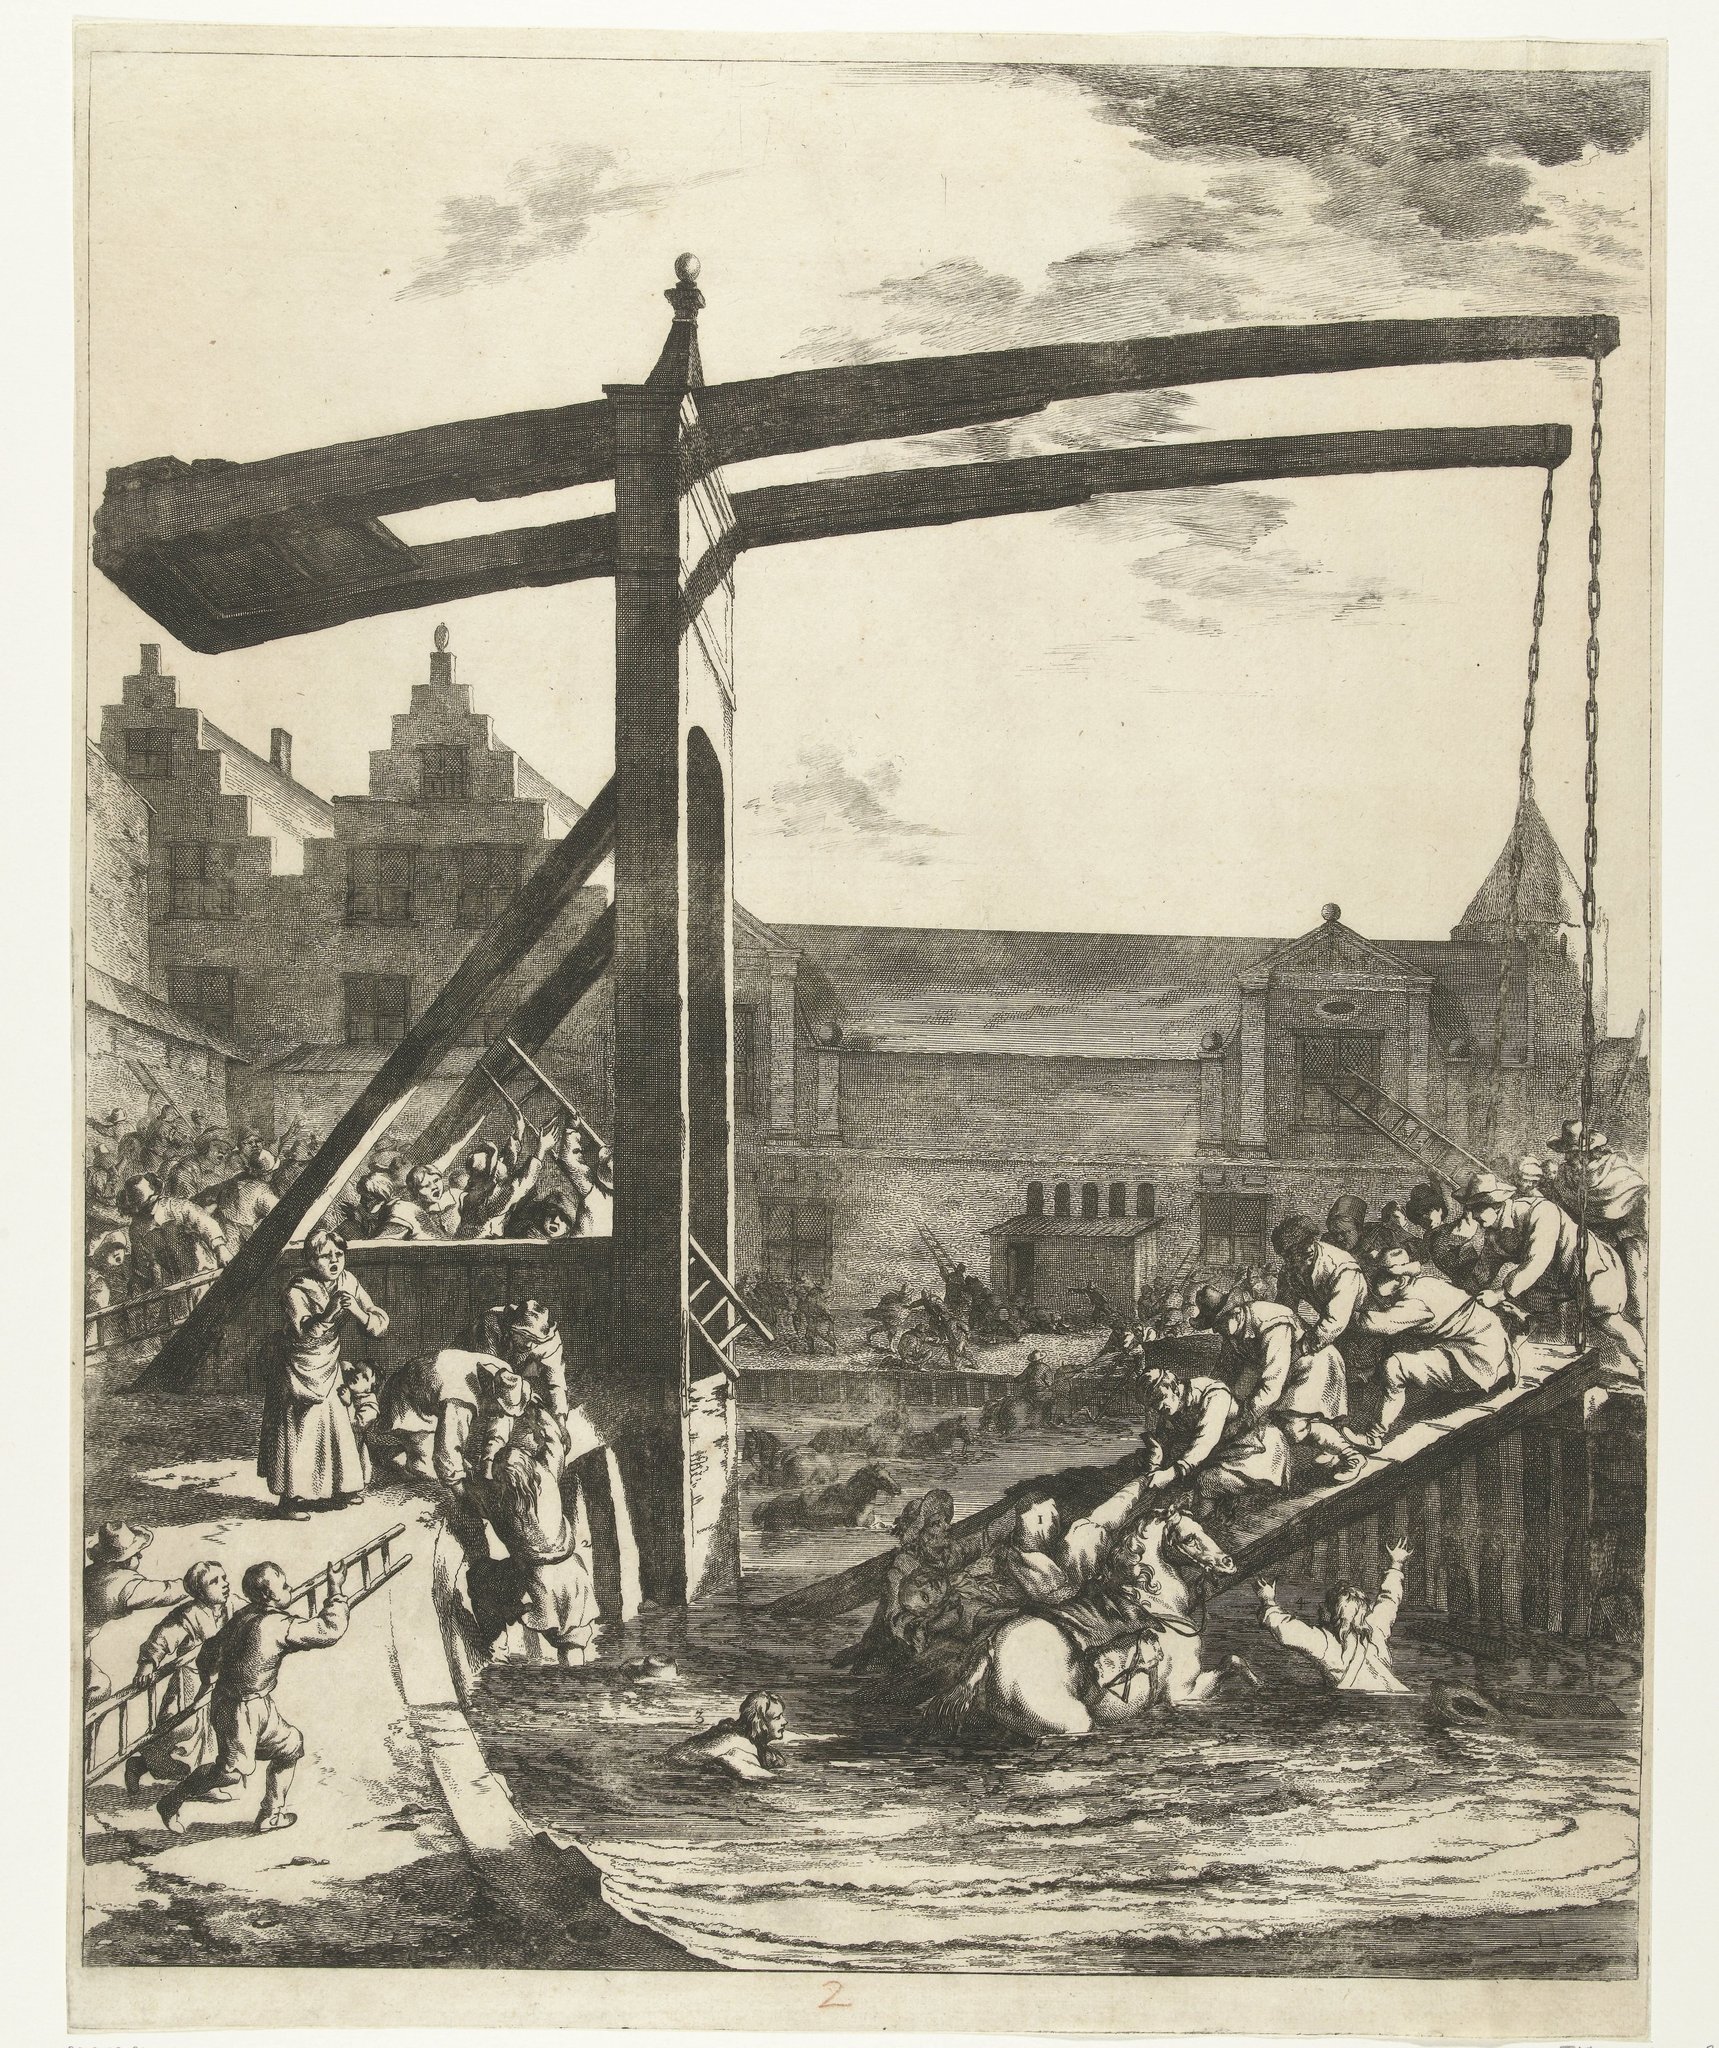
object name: print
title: Redding van graaf Johan Maurits na het ongeluk op de brug van Franeker, 1665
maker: jan de visscher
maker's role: print maker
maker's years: 1633-1712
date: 1665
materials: paper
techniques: etching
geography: northern netherlands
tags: johan maurits graaf van nassau-siegen, collapsing building, bridge, accident with horse (or kindred animal), saving a person from drowning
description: Redding van graaf Johan Maurits na het ongeluk op de brug van Franeker, 1665, 6 januari 1665. De ophaalbrug waar de graaf met zijn gevolg overheen reed is ingestort. De graaf wordt uit het water gehaald, omstanders komen met ladders aangesneld. De figuren in de voorstelling genummerd 1-3.